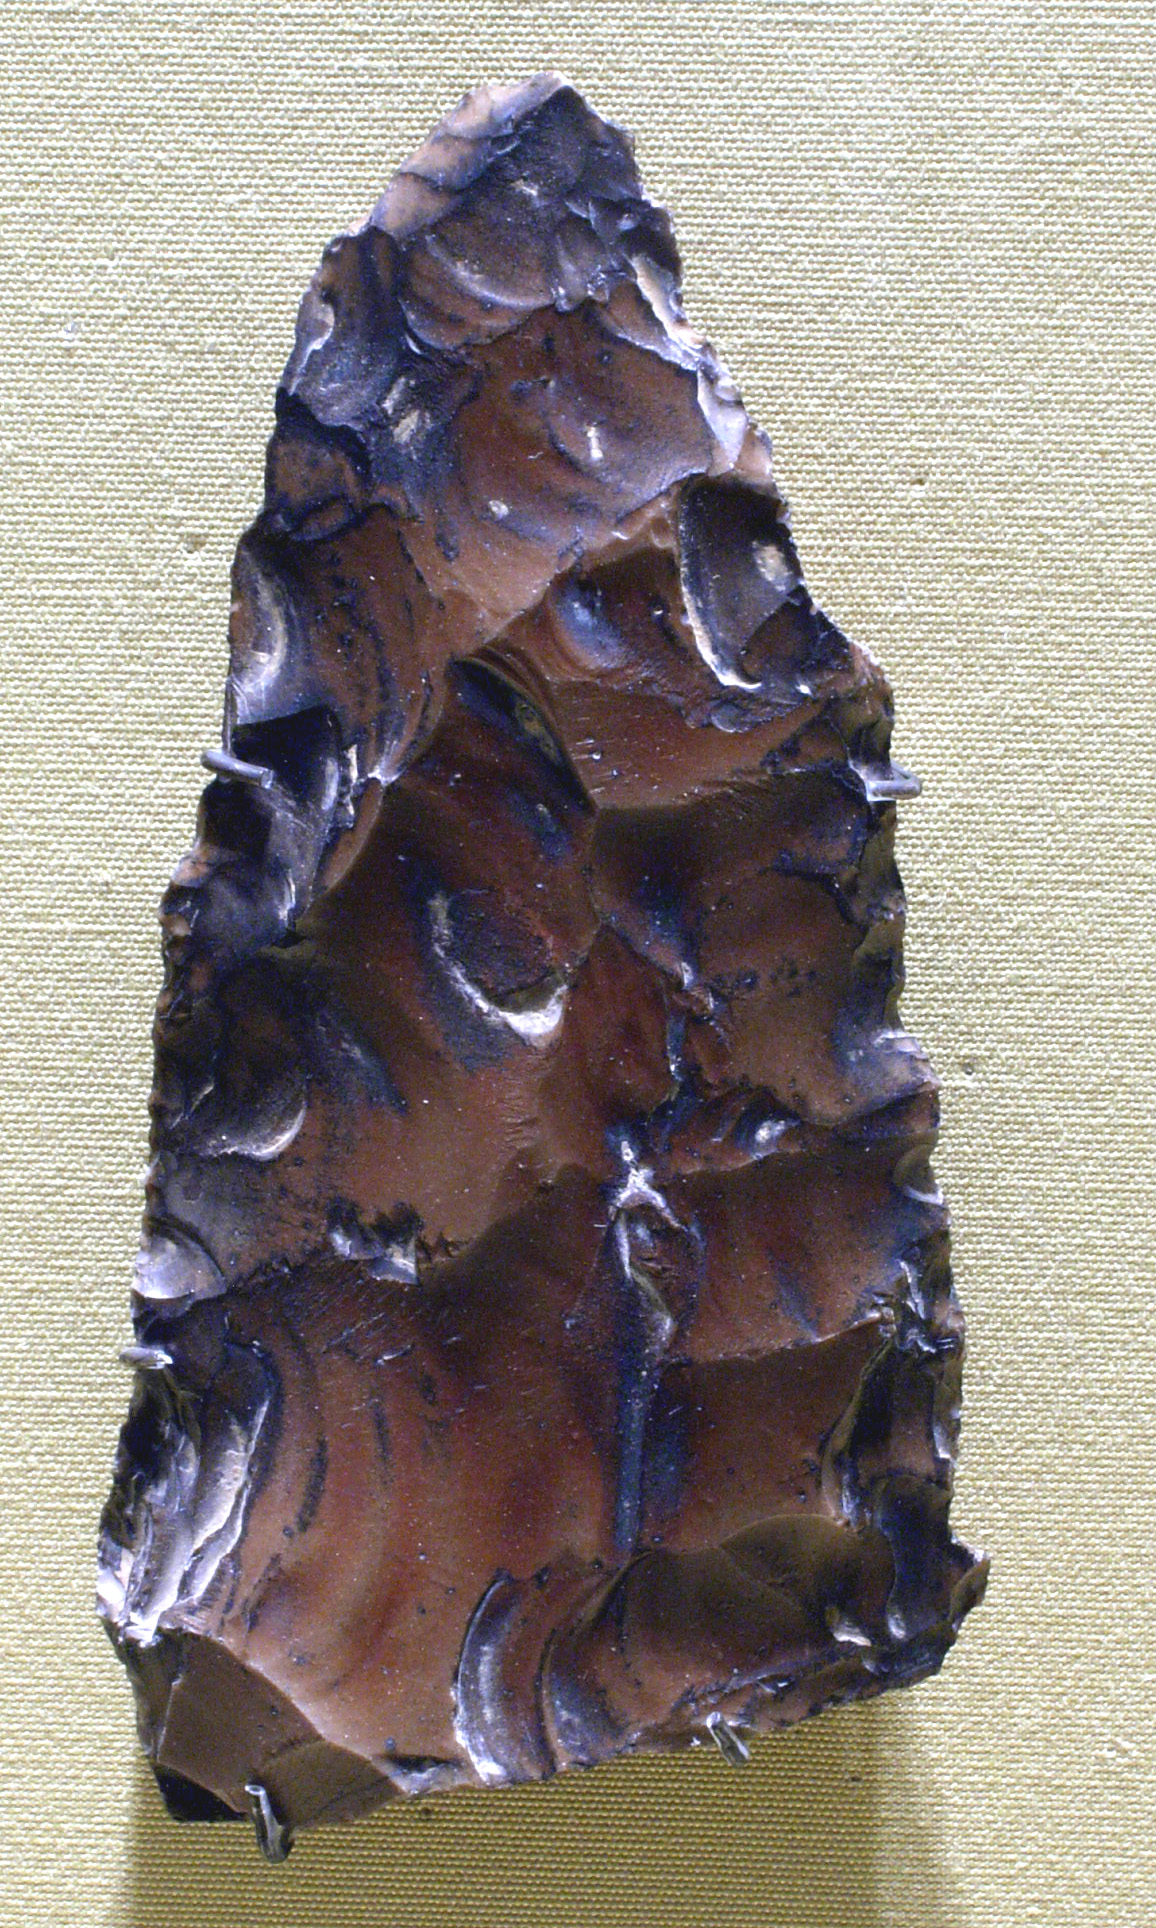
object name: tool, biface, hand ax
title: Biface, commonly referred to as a hand ax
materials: stone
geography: egypt